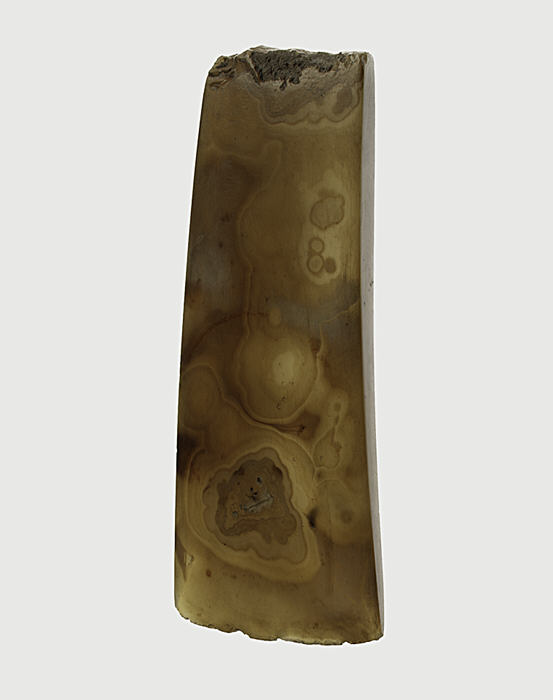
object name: ceremonial ax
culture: indonesian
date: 500 BCE-300 CE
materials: stone